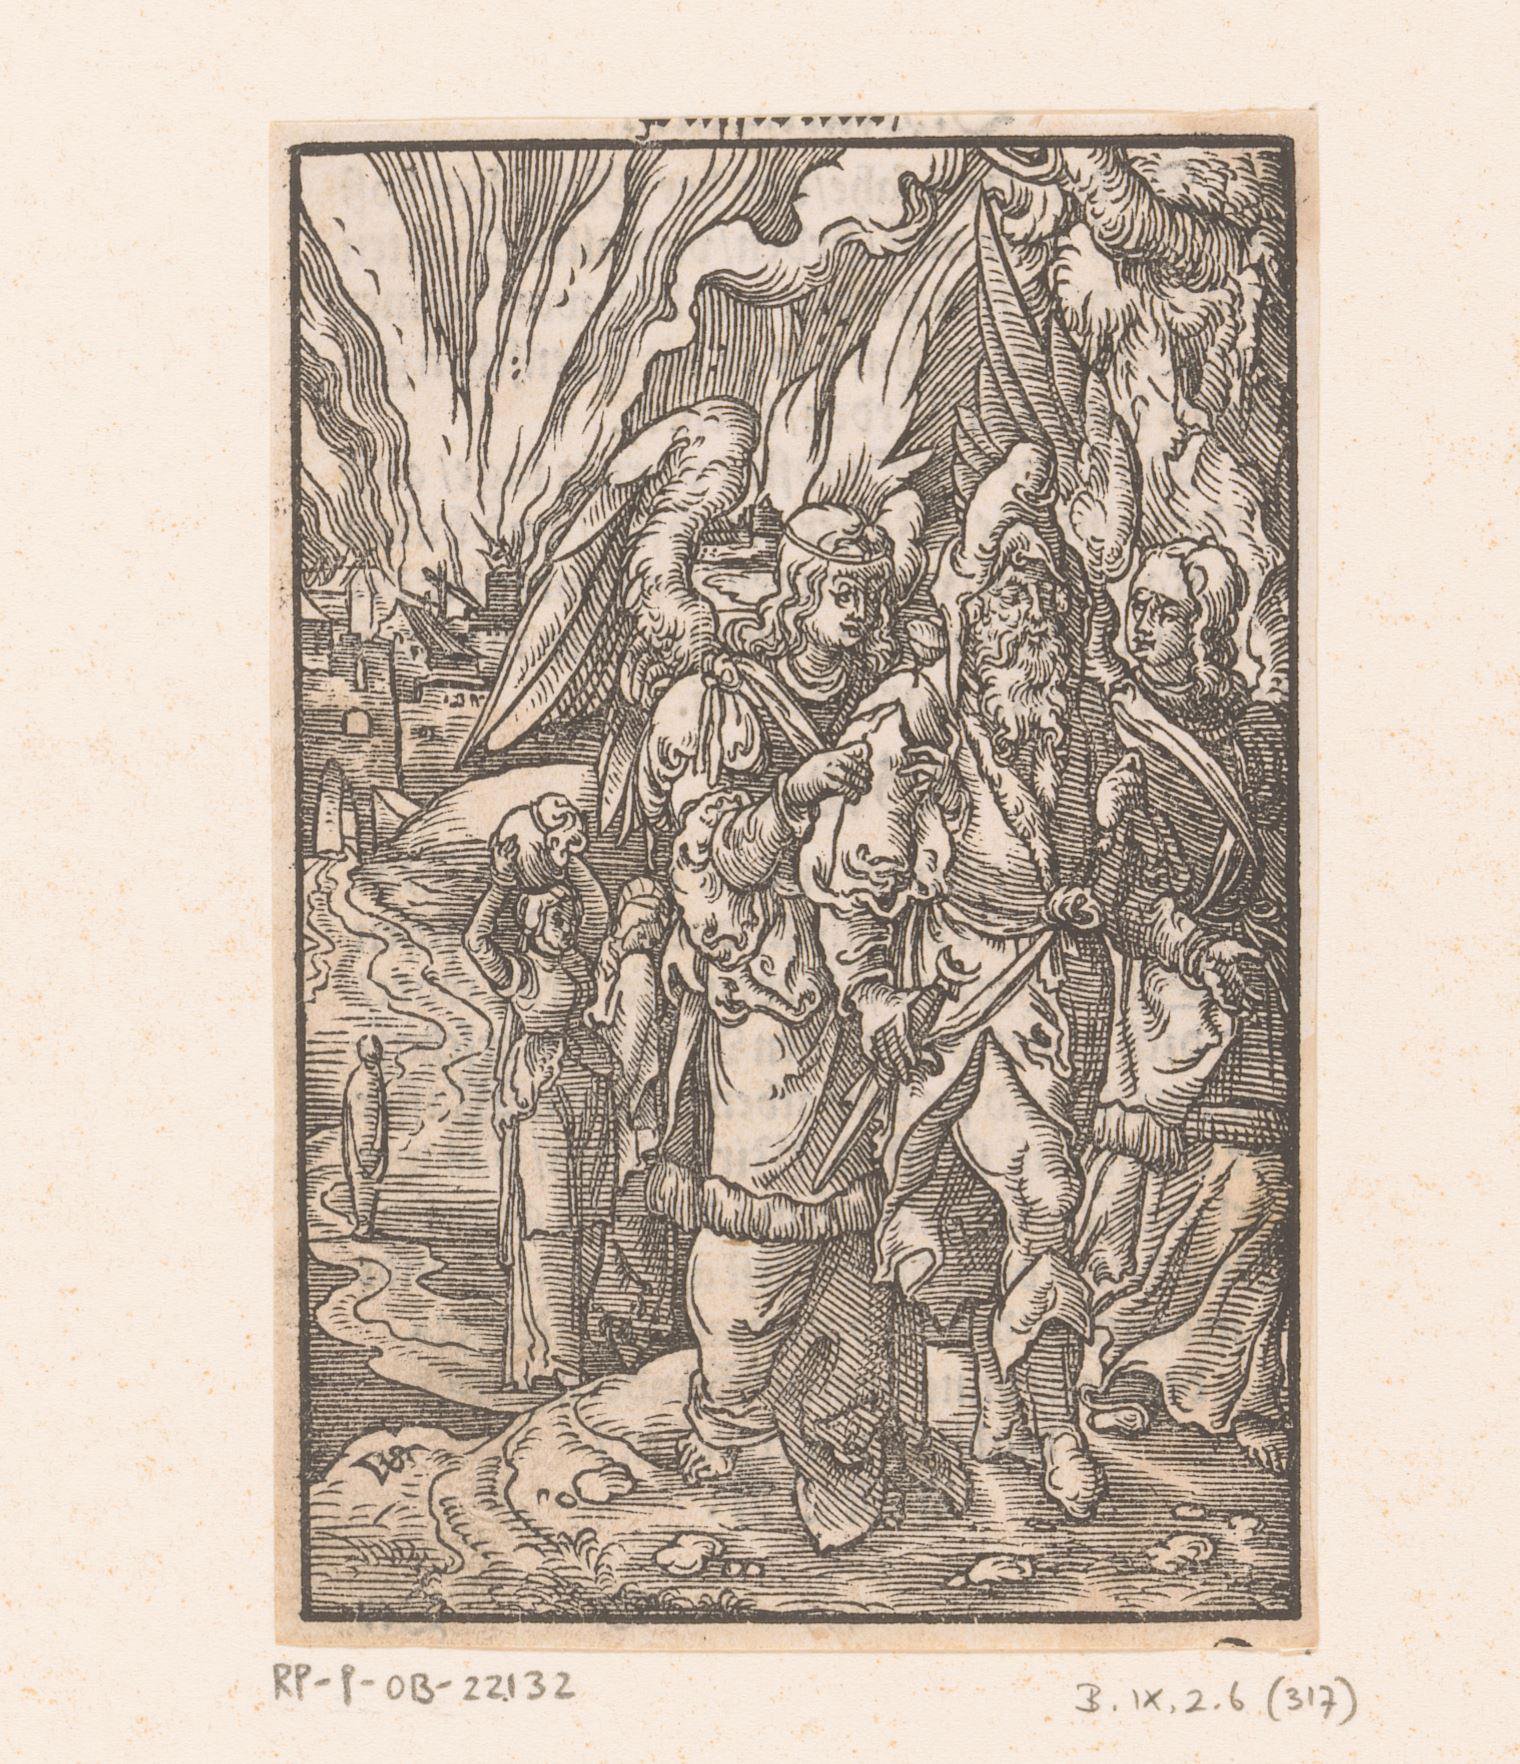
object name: print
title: Lot en zijn dochters verlaten het brandende Sodom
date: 1552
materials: paper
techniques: woodcut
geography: nuremberg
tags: the destruction of sodom and gomorrah: lot and his family flee to zoar, carrying their belongings; an angel may be showing the way (genesis 19:24-29), lot's wife looks back at the city and is transformed into a pillar of salt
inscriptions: number: ‘181’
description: Gebruikt voor verschillende publicaties die werden gedrukt door Valentin Geißler tussen 1552 en 1560 te Neurenberg.